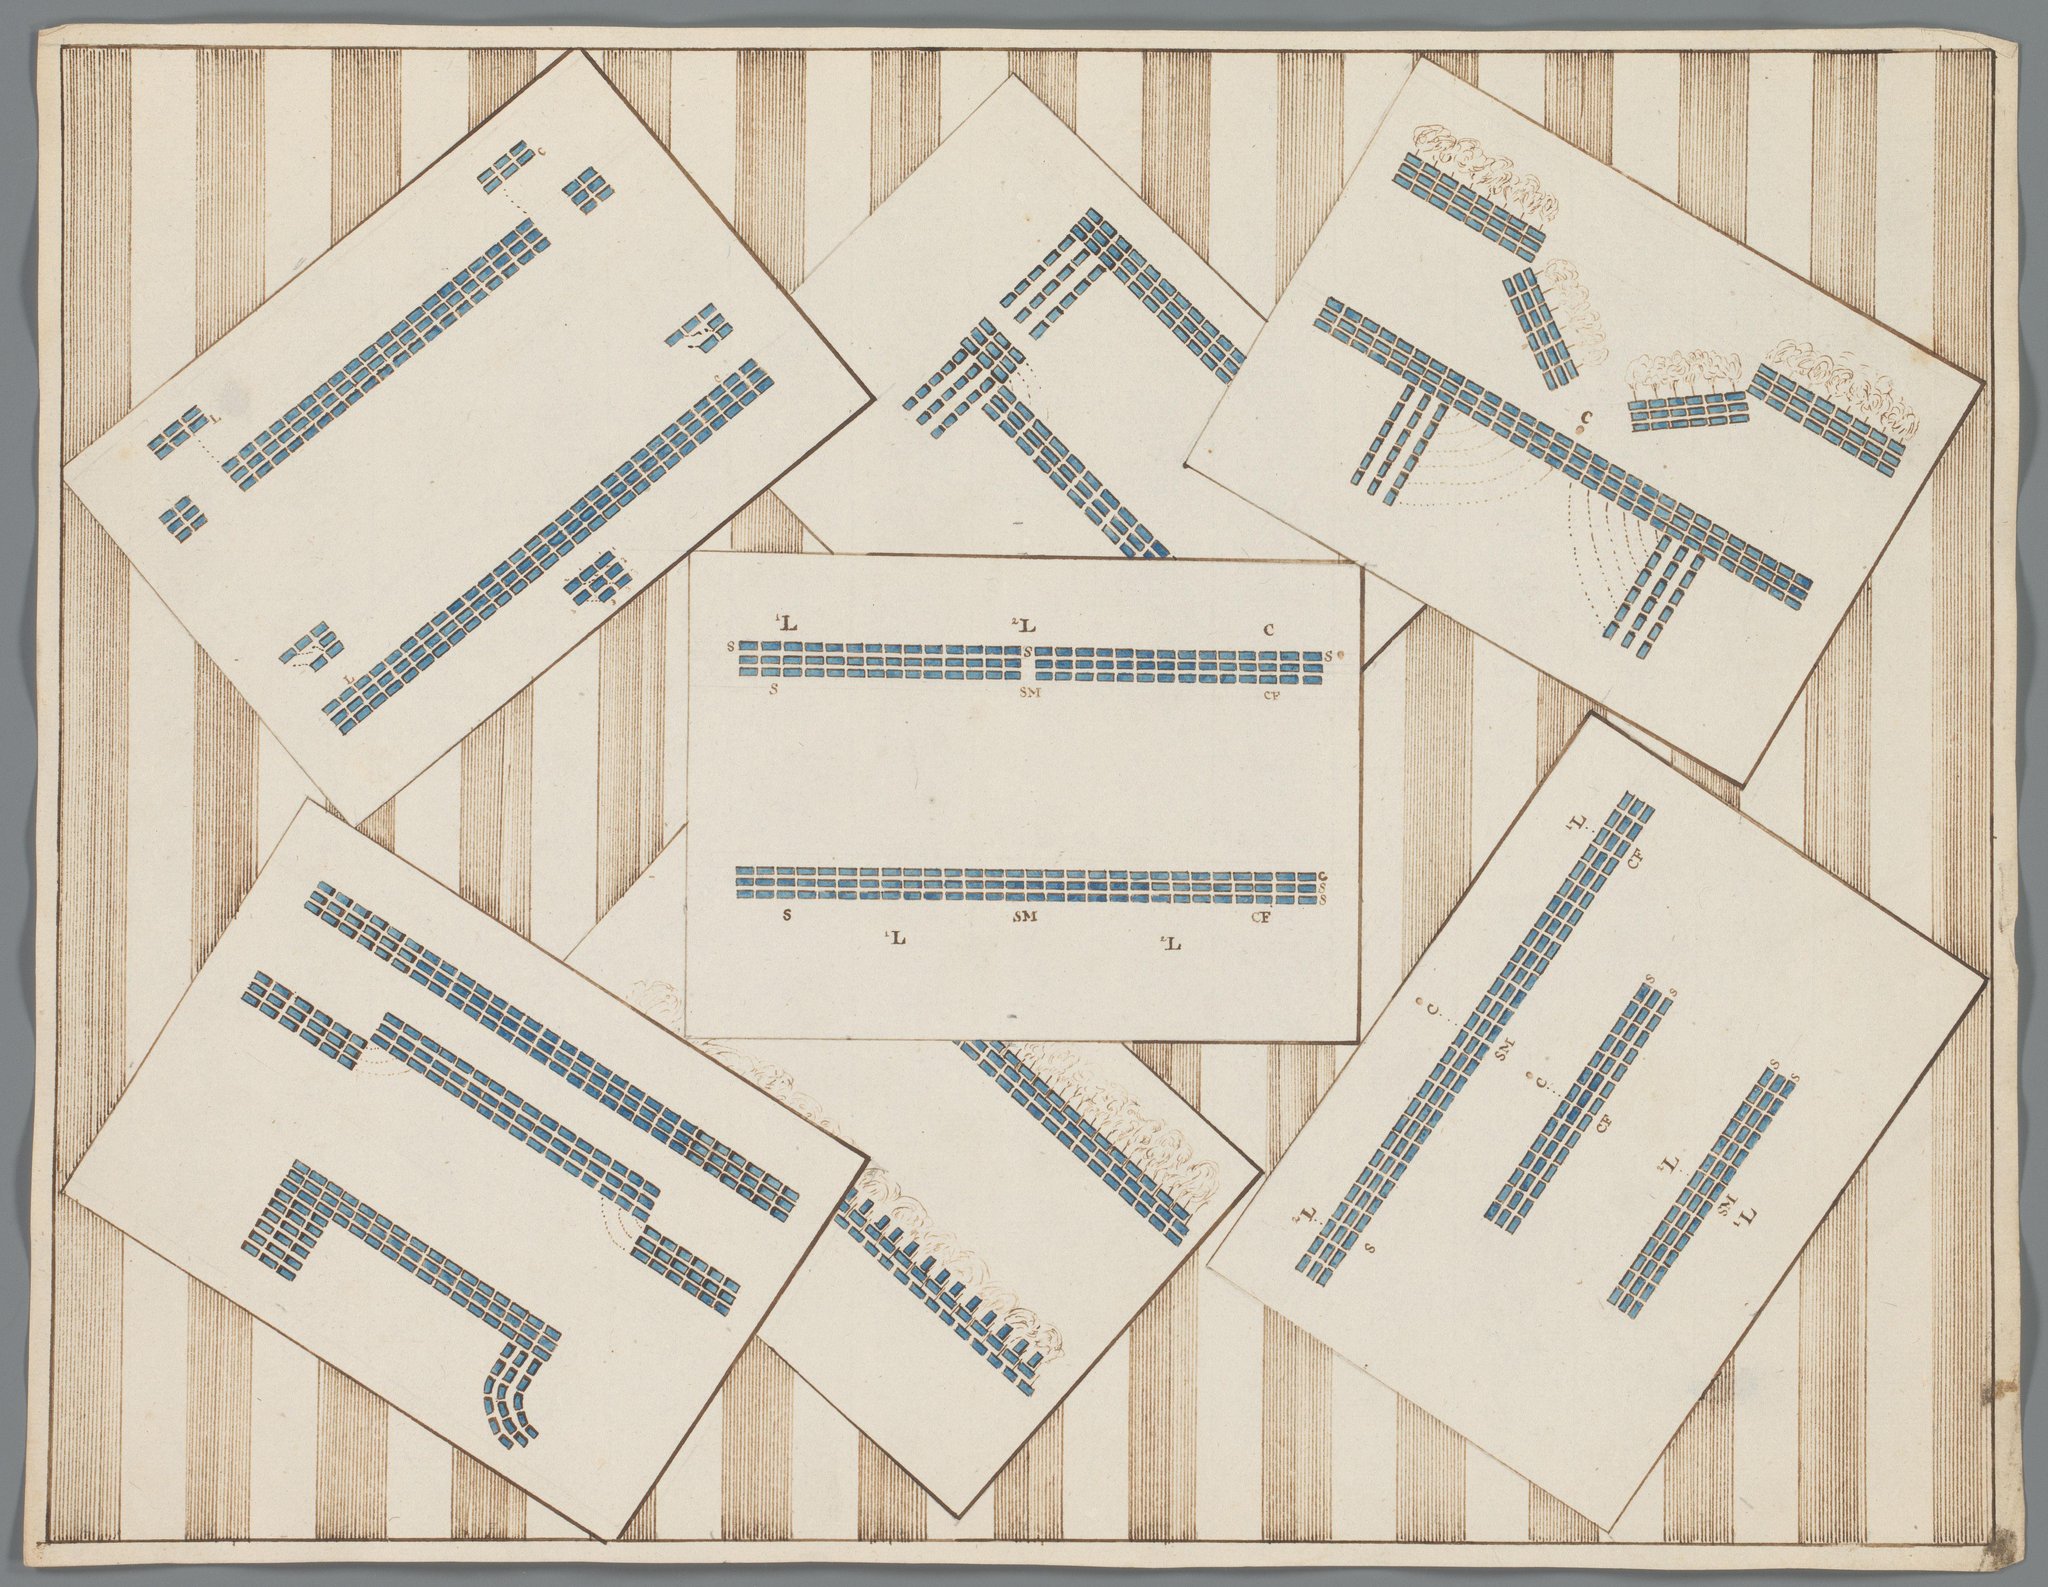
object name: drawing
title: Manoeuvres van de compagnieën, ca. 1799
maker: hendrik van der poth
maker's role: draughtsman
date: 1799-1803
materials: paper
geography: netherlands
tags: manoeuvre ~ military training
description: Blad met zeven kaartjes van verschillende manoeuvres van de zeven compagnieën van het Bataafse bataljon. Ten tijde van de Brits-Russische expeditie in 1799. Onderdeel van een groep van zeventien getekende kaarten.